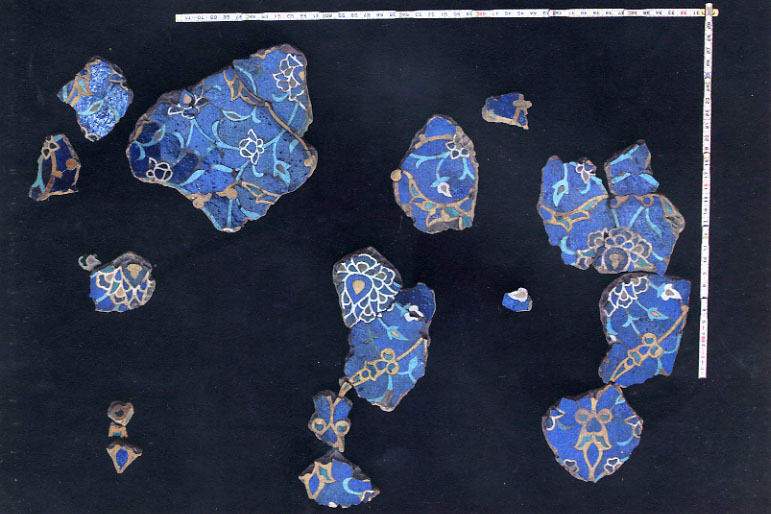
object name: tile fragment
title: A Group of Mosaic Tilework Fragments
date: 1476-1500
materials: clay, stonepaste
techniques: glazing, polychrome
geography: iran